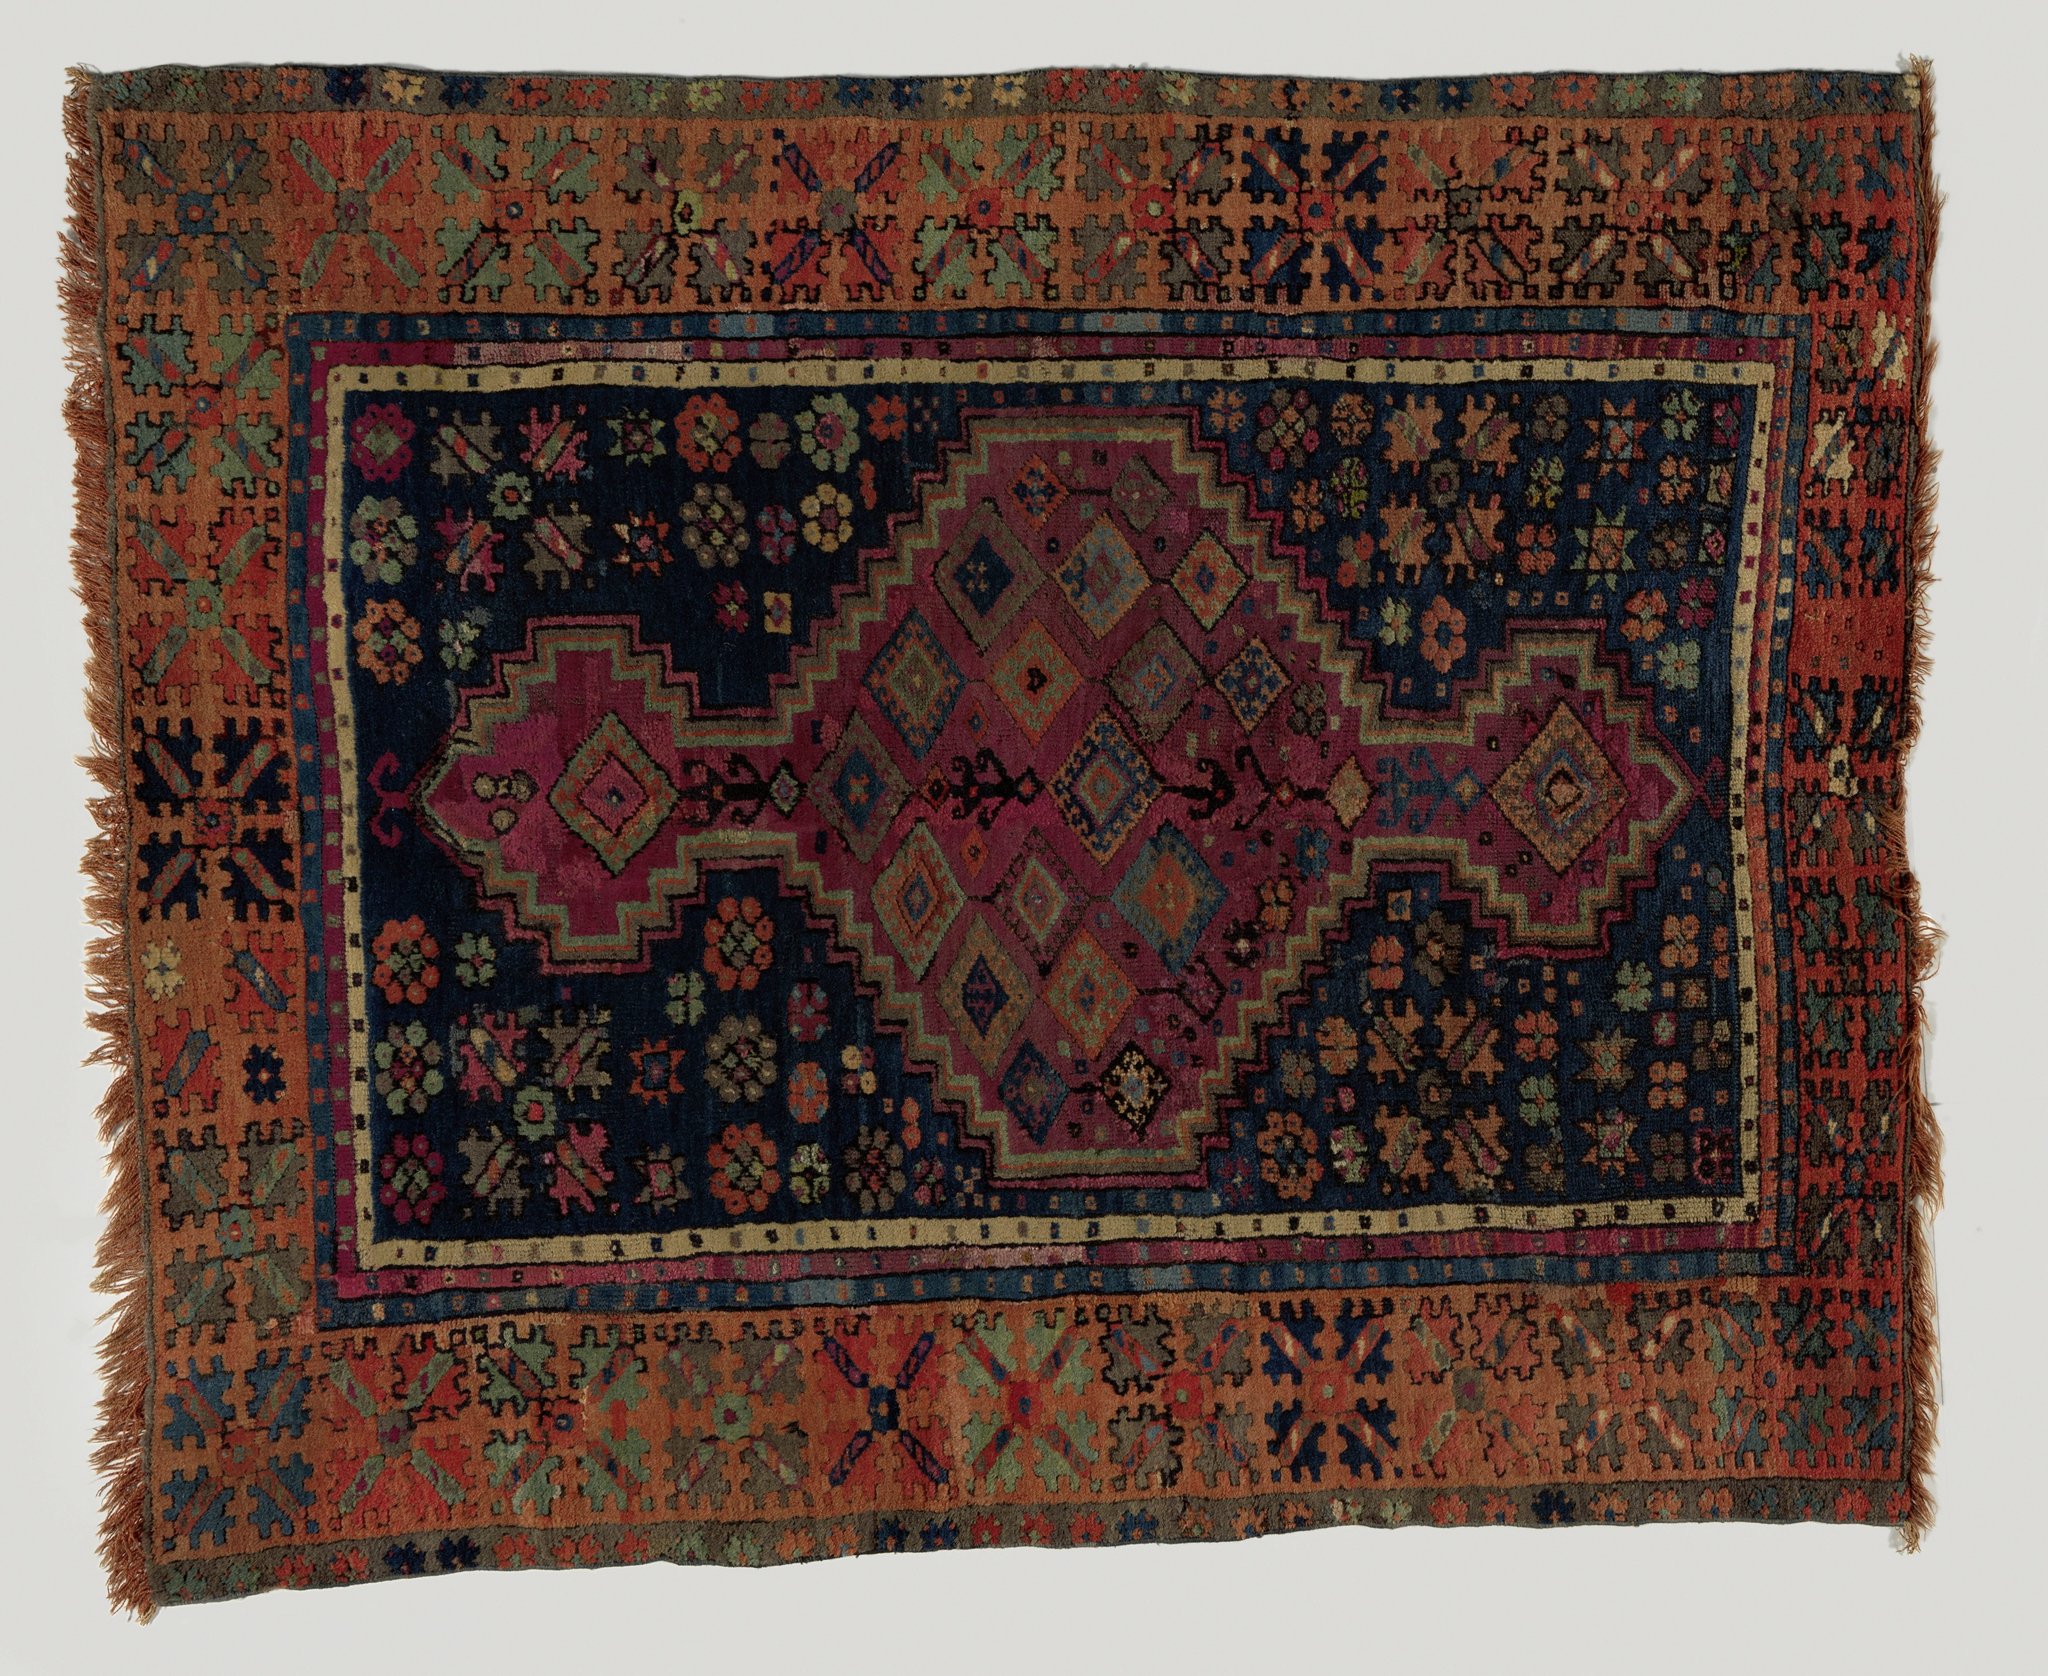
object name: oriental rug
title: Medaillonkleed, YURUK of SULTAN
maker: Anonymous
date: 1800-1900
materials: wool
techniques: ghiordes knot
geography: southeast asia minor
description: Medaillonkleed, Yuruk of "Sultan". Middenveld: donkerblauw fond met een kardinaalspaars medaillon met uitlopers aan kop en staart en gevuld met ruiten in vele gedempte kleuren. Veldvulling van vier grote bloemen in kaleidoskopische kleurvakjes verdeeld en vele kleine rozetten. Rand: veelvoudig. De breedste is oranje, waarop kruisbloemen staan. Drie effen binnenlijsten in wit, cerise en blauw. De buitenzoom is bruin.